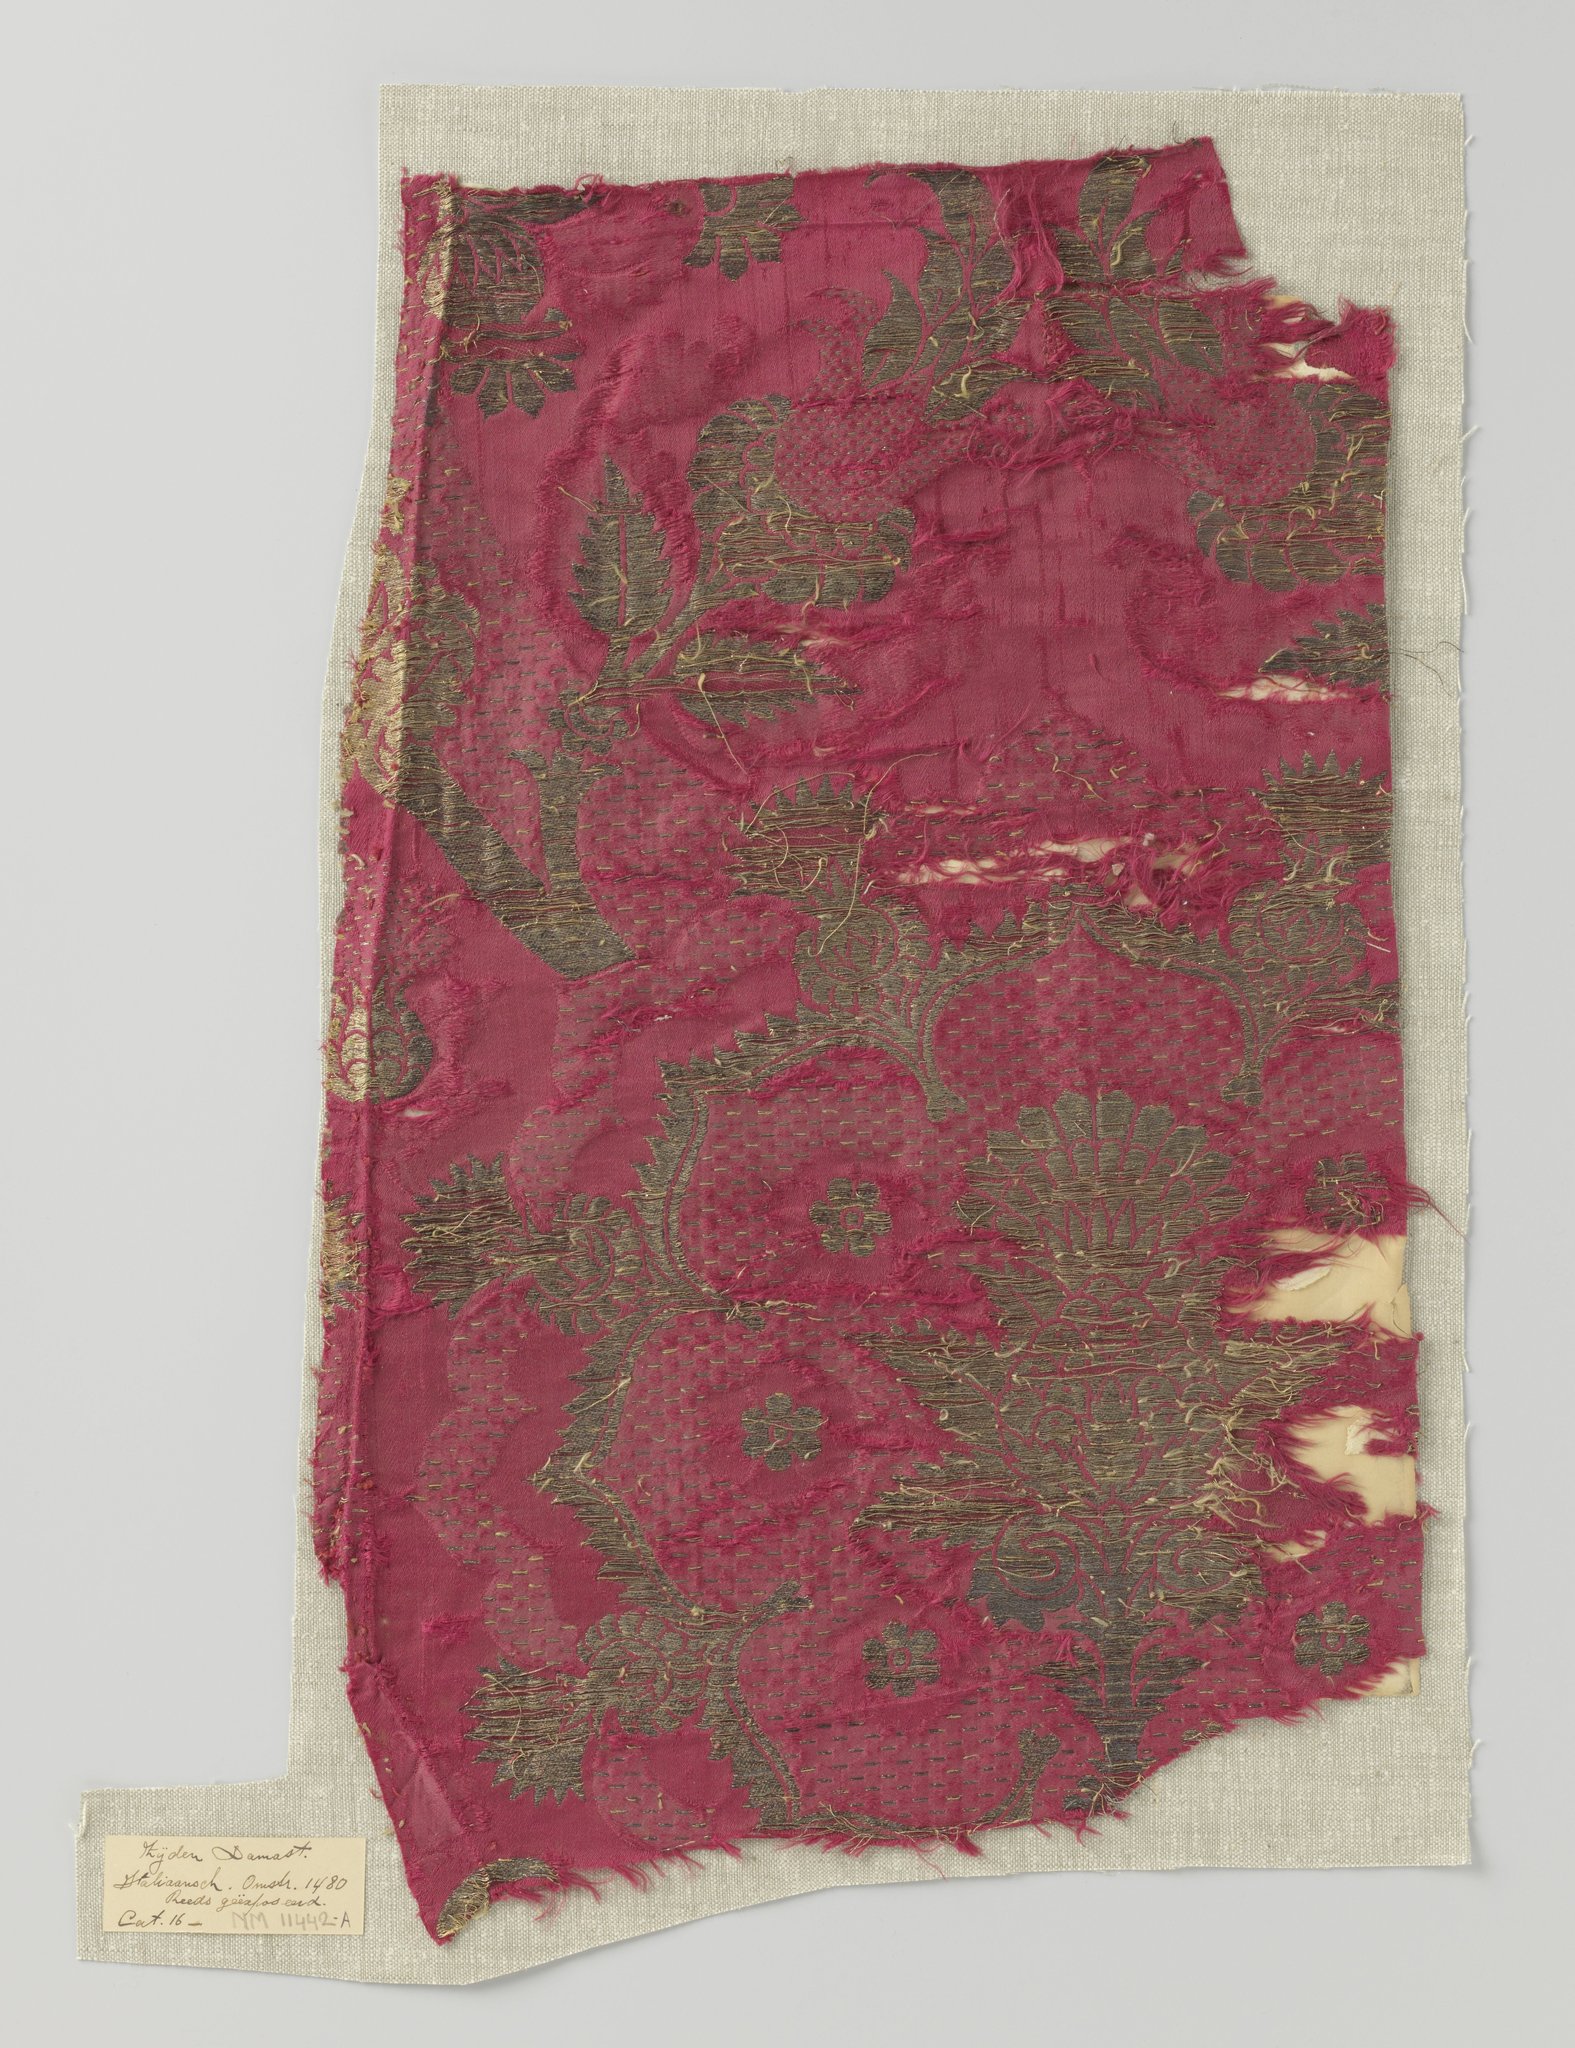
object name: damastbrokaat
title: Fragment rood damastbrokaat met granaatappelmotieven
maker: Anonymous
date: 1450-1499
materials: gold thread, silk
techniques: brocade, damask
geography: italy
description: Fragment van rode zijden damastbrokaat met granaatappelmotieven.